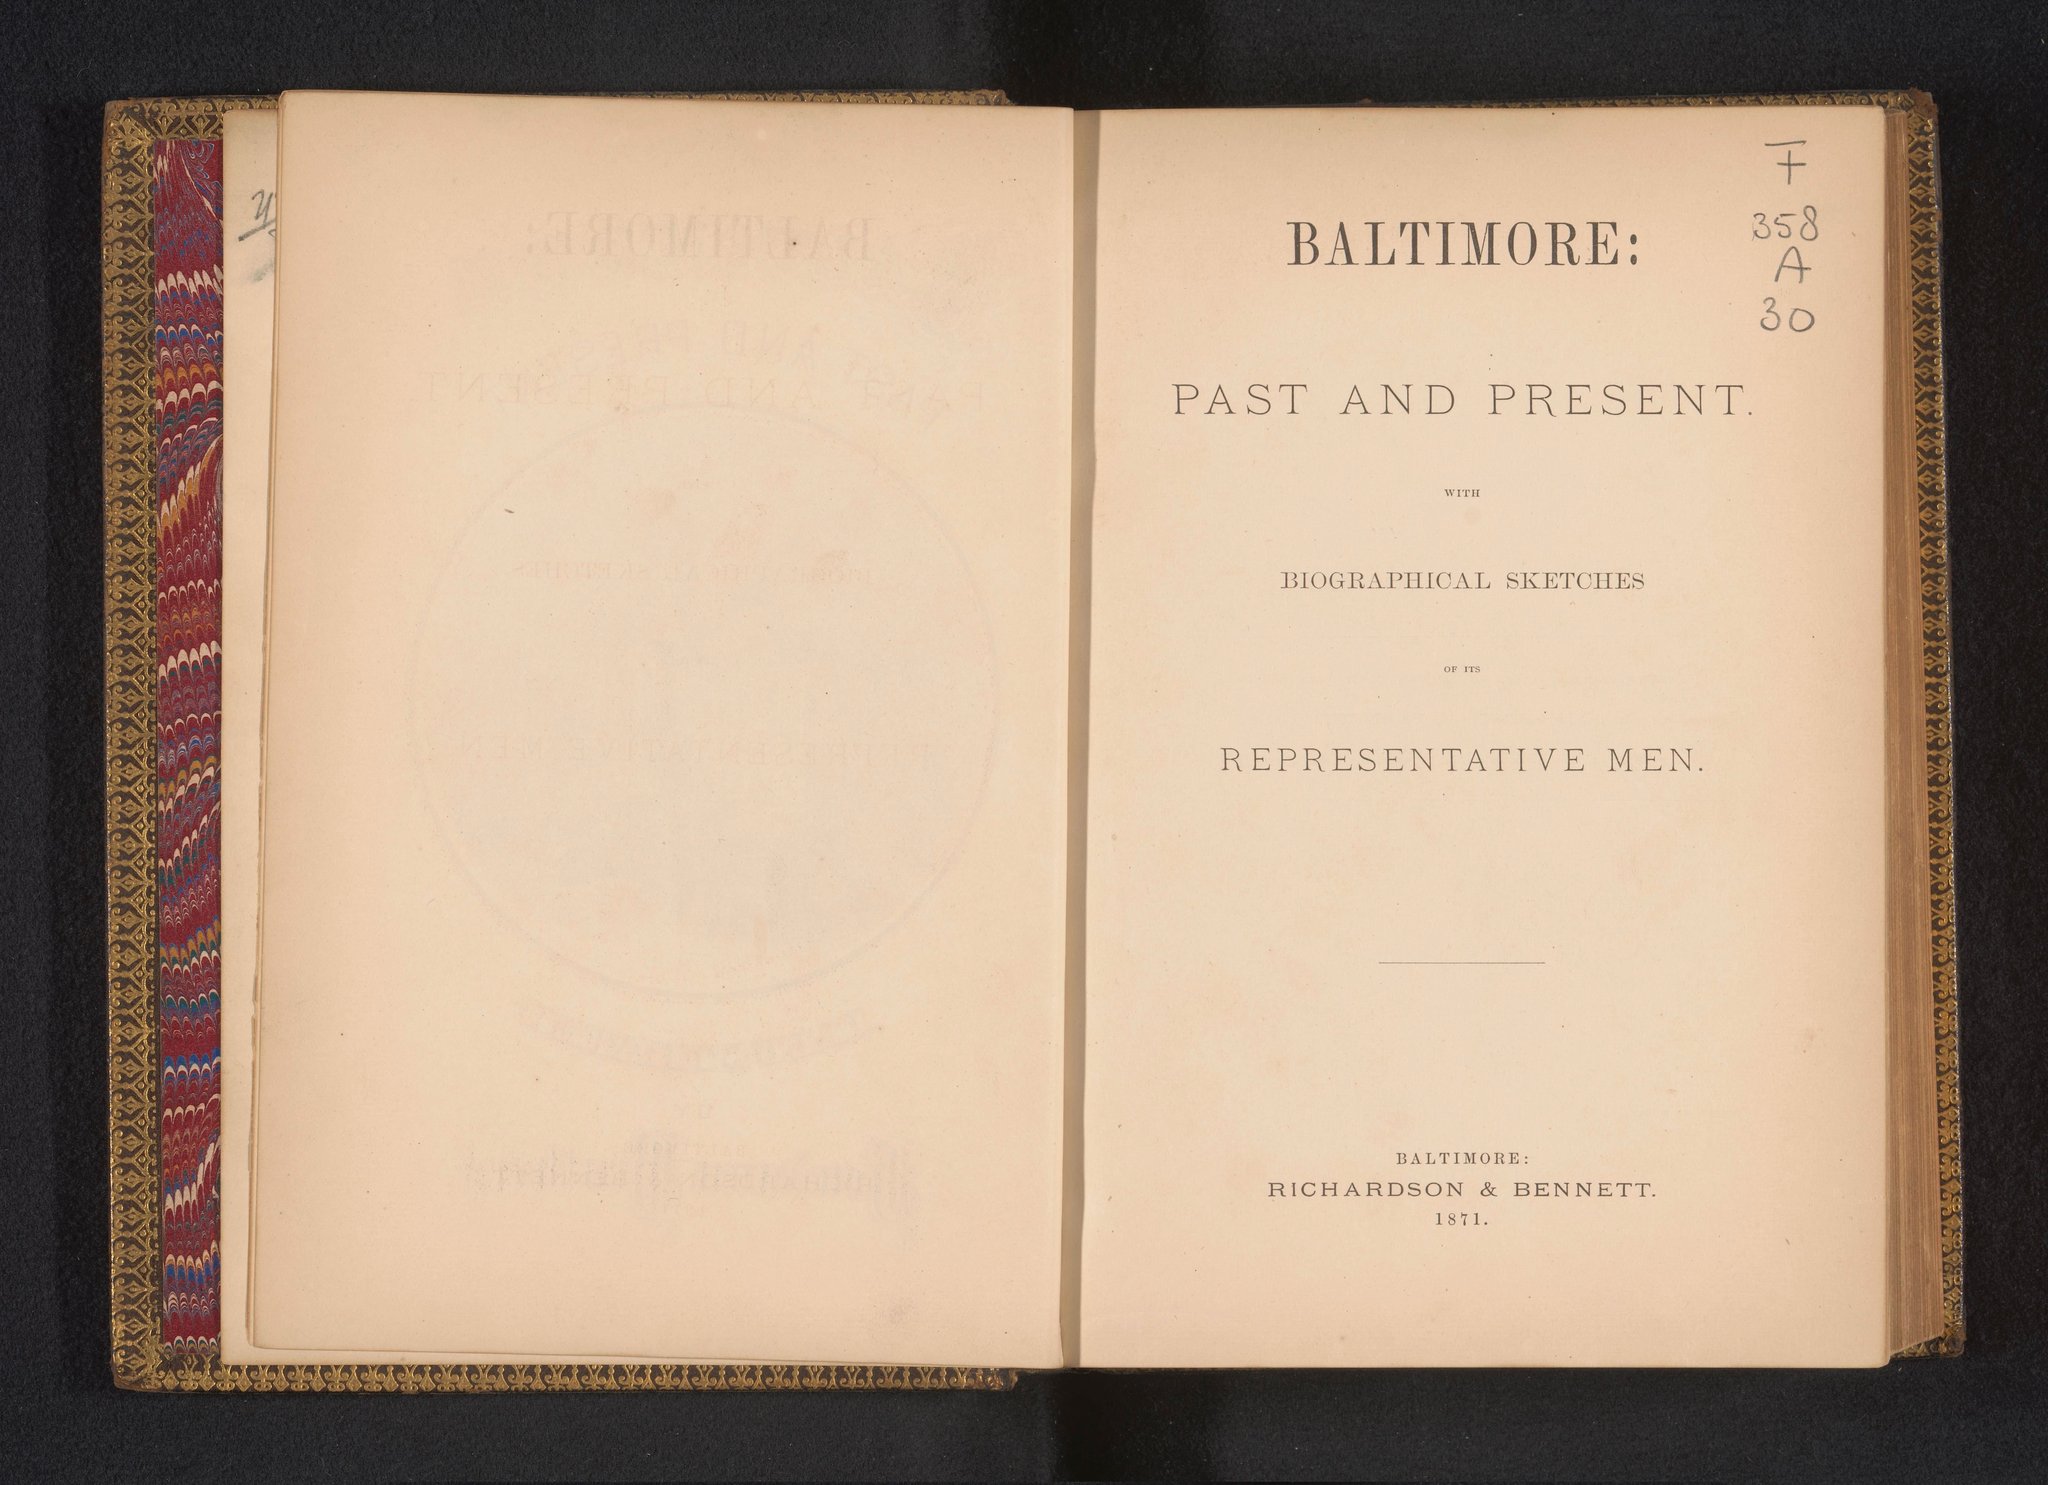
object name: book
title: Baltimore : past and present with historial sketches of its representative men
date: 1871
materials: linen, paper, photographic support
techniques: albumen print, printing, marbled paper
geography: baltimore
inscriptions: annotation: ‘62 Bendann Brothers photographs 1871’, date: ‘Nov 1996’